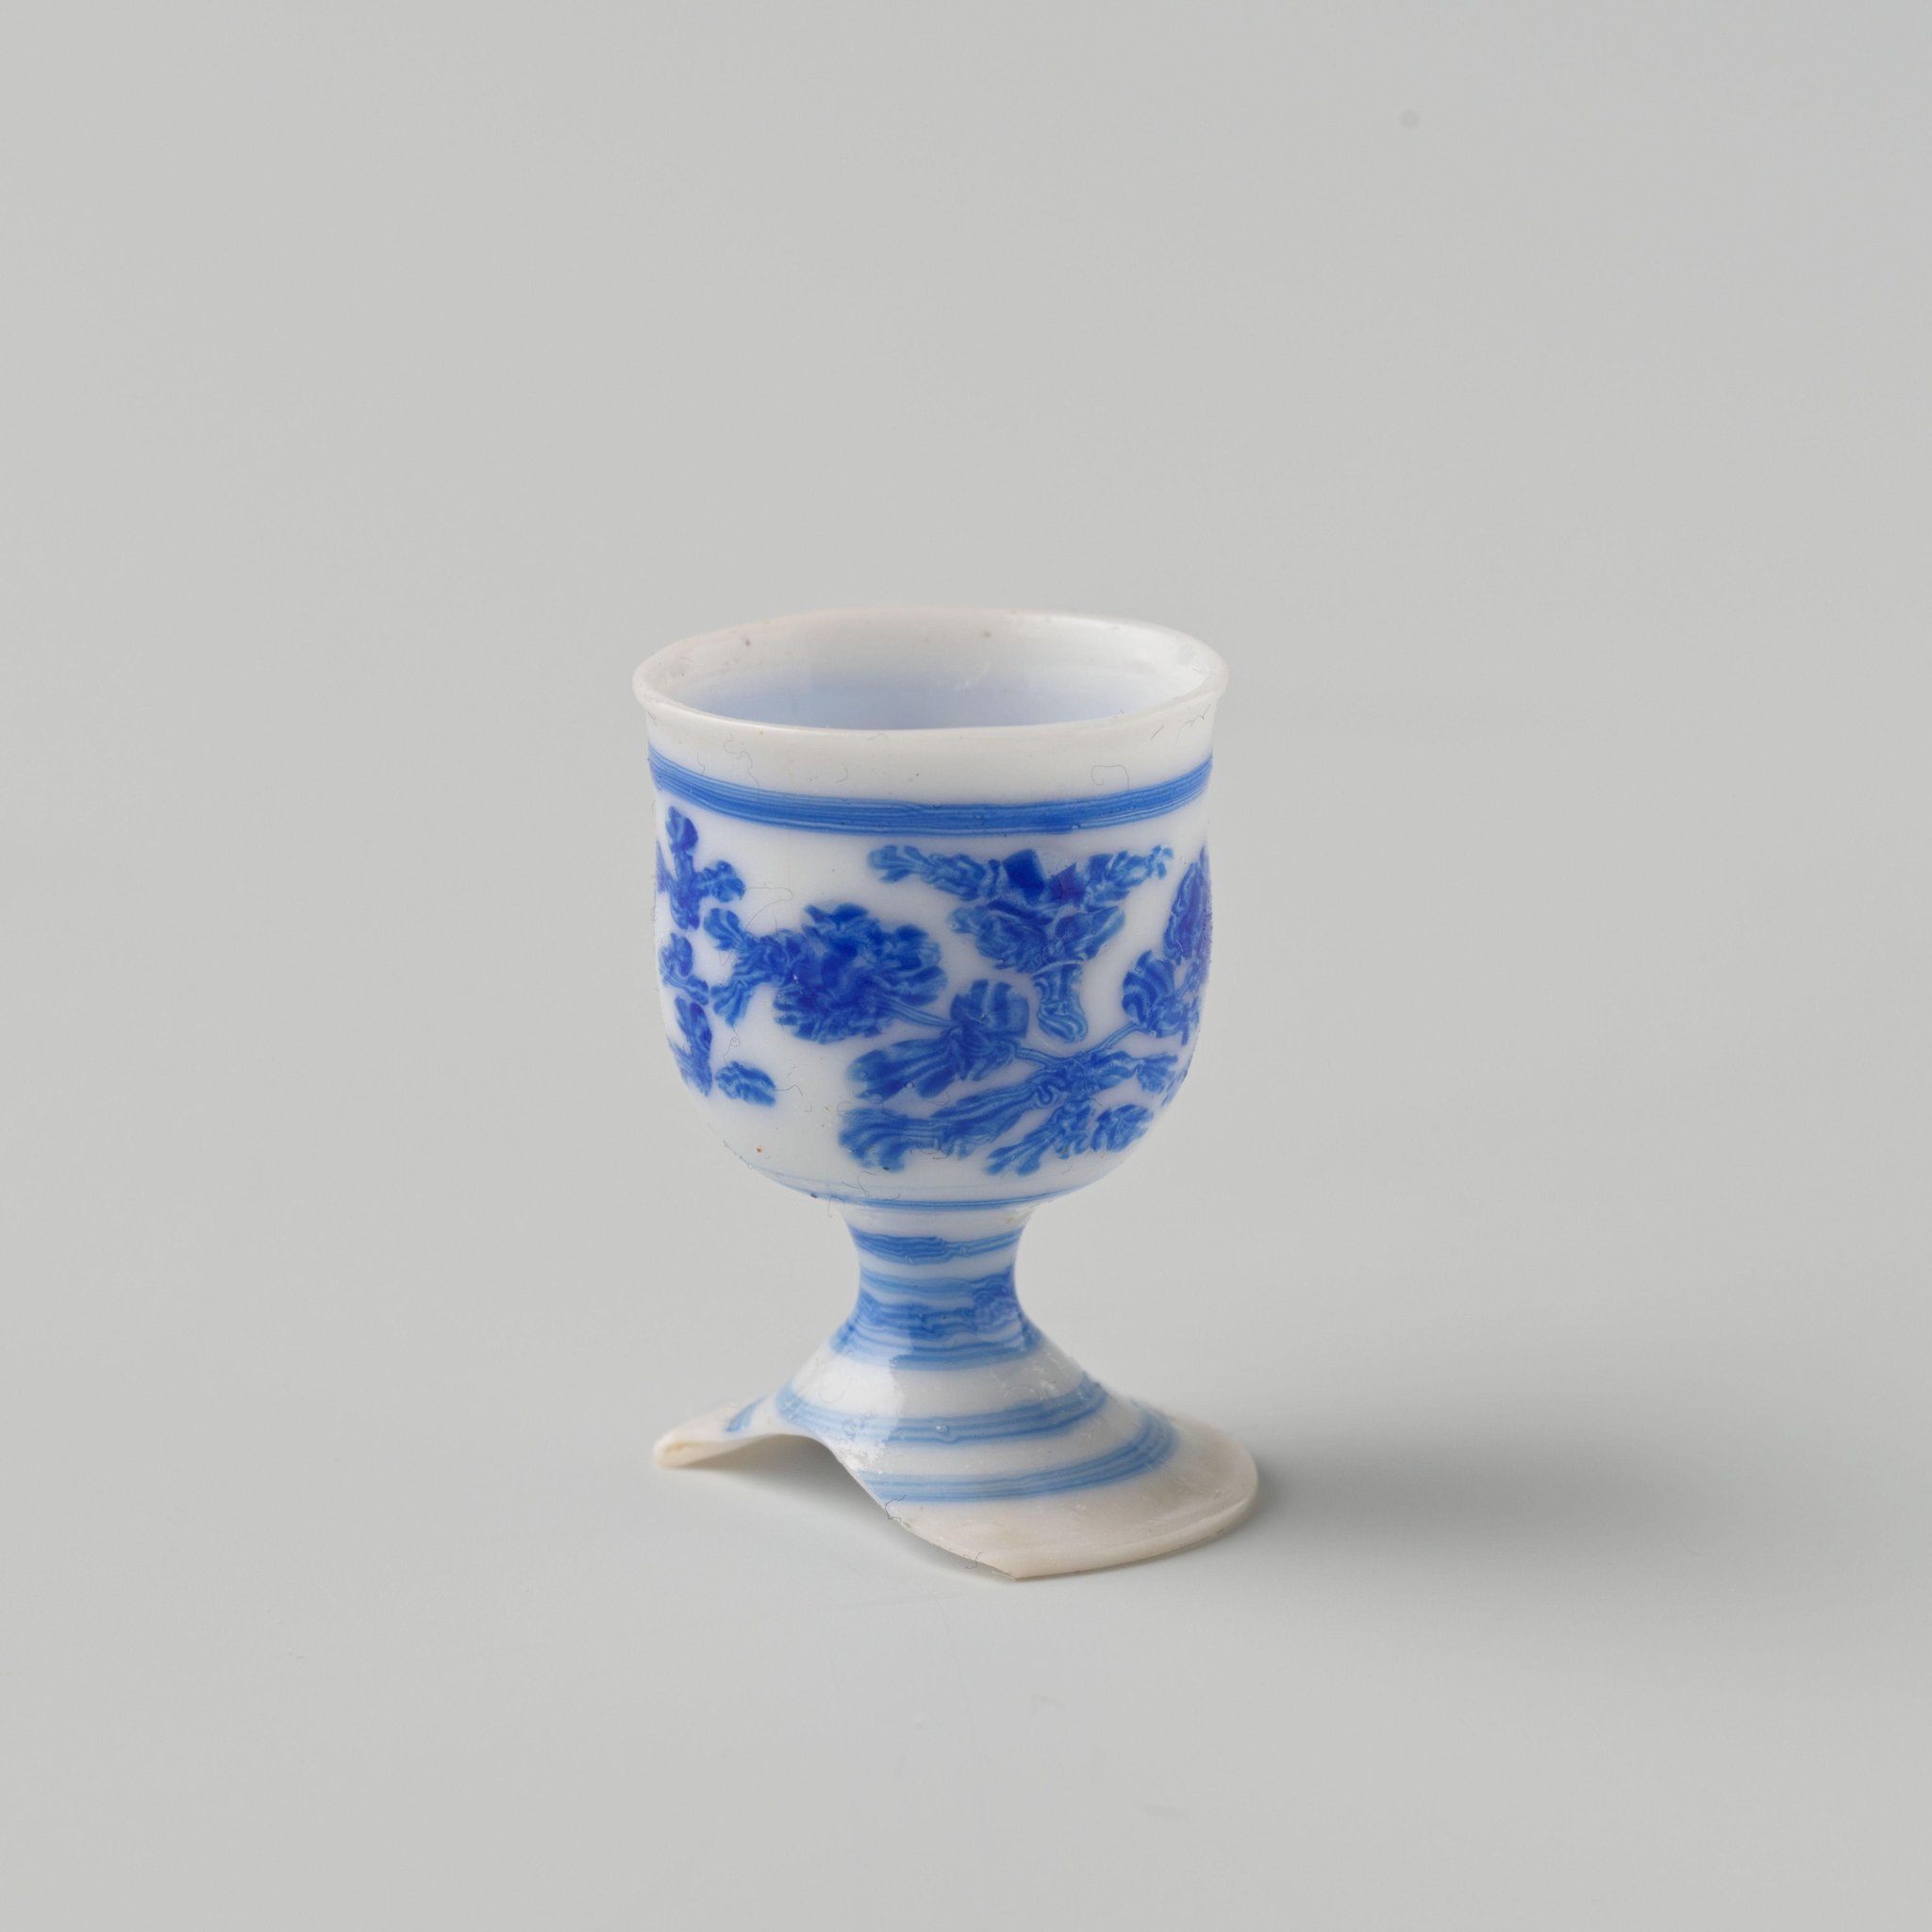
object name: miniature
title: Beker op voet van melkglas met blauwe emailverf beschildering, imitatie Chinees porselein; kelkvormige cuppa op korte stam, versierd met ringen, bloemmotieven op de kelk.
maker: Anonymous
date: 1675-1710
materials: glass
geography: amsterdam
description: Beker op voet van melkglas met blauwe emailverf beschildering, imitatie Chinees blauw porselein; kelkvormige cuppa op korte stam en iets oplopende voet, versierd met ringen, bloemmotieven op de kelk.